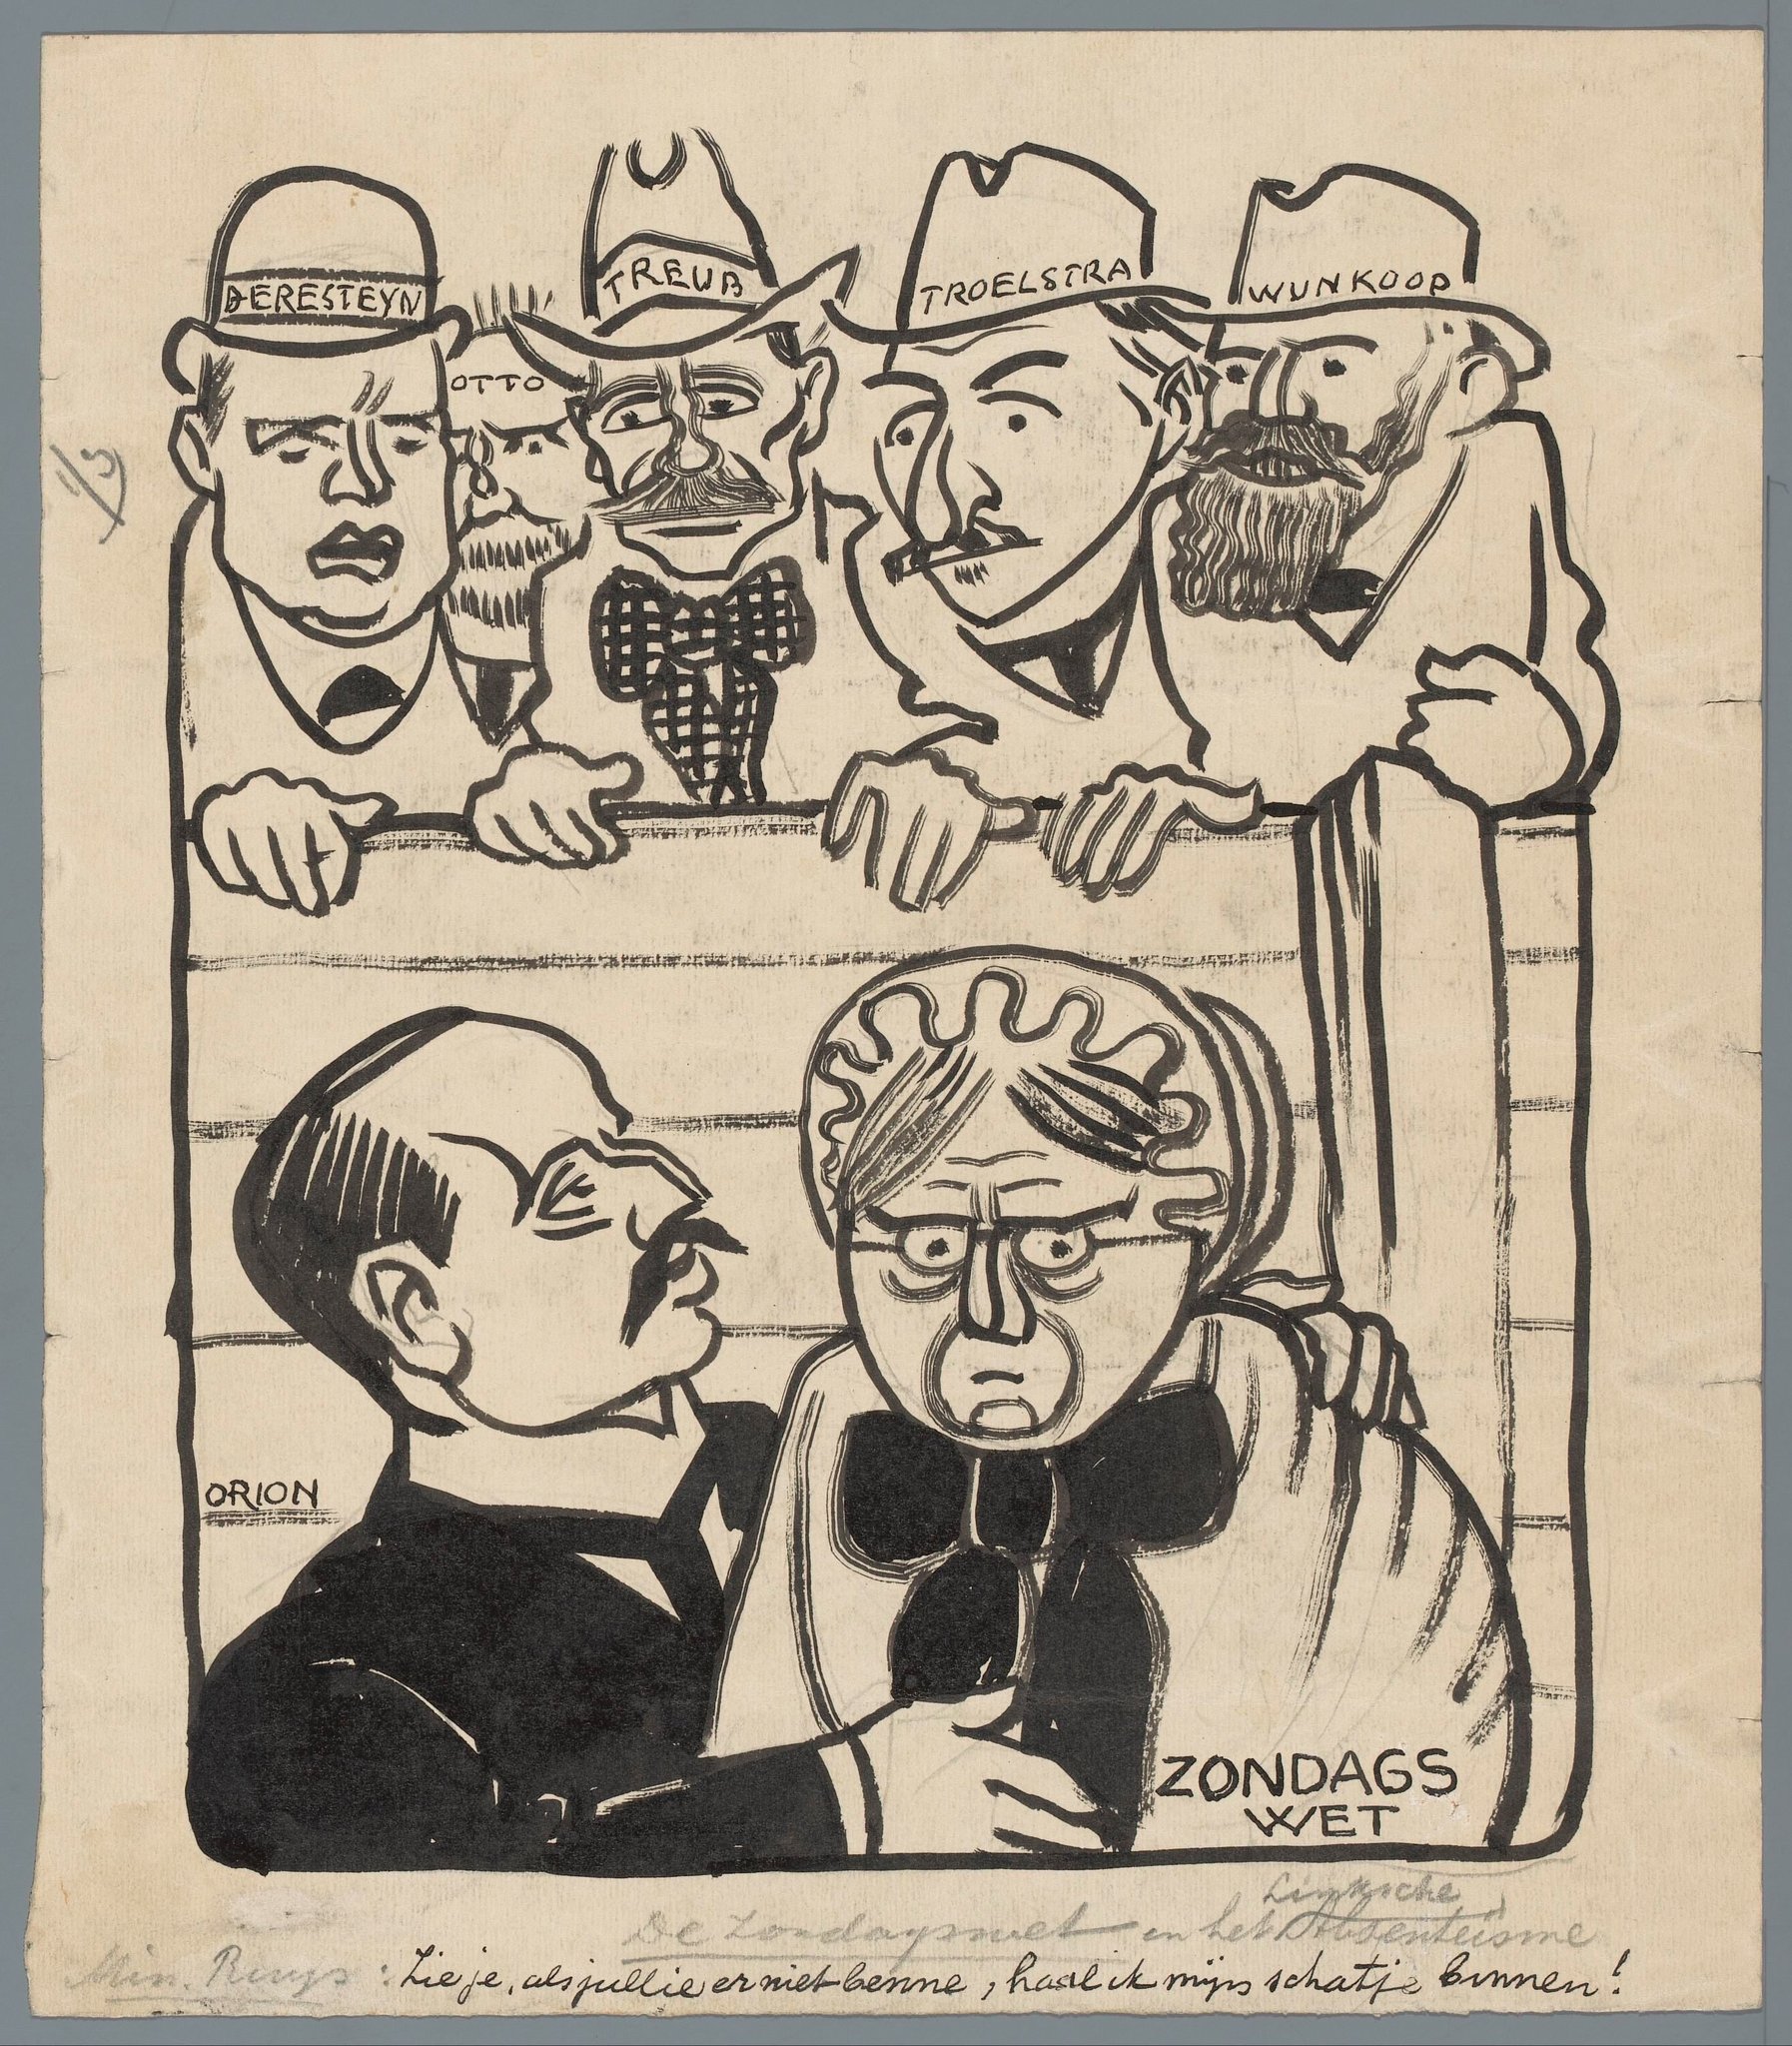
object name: cartoon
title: De Zondagswet en het Linksche Absenteisme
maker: patricq kroon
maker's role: draughtsman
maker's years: 1862-1941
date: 1900-1930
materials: ink, paper, pencil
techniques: brush, pen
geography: netherlands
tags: voorschoten, haarlem, the hague, politician, eeltjo aldegondus van beresteijn, political caricatures and satires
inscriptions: inscription: ‘De Zondagswet en het Linksche Absenteisme / Min. Ruys: Zie je, als jullie er niet benne, haal ik mijn schatje binnen!’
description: Minister Ruijs de Beerenbrouck met een oude vrouw aangeduid als de Zondagswet. Vanachter een schutting kijken vijf linkse politici (Beresteyn, Otto, Treub, Troelstrat en Wijnkoop) toe. Ontwerp voor een politieke spotprent.